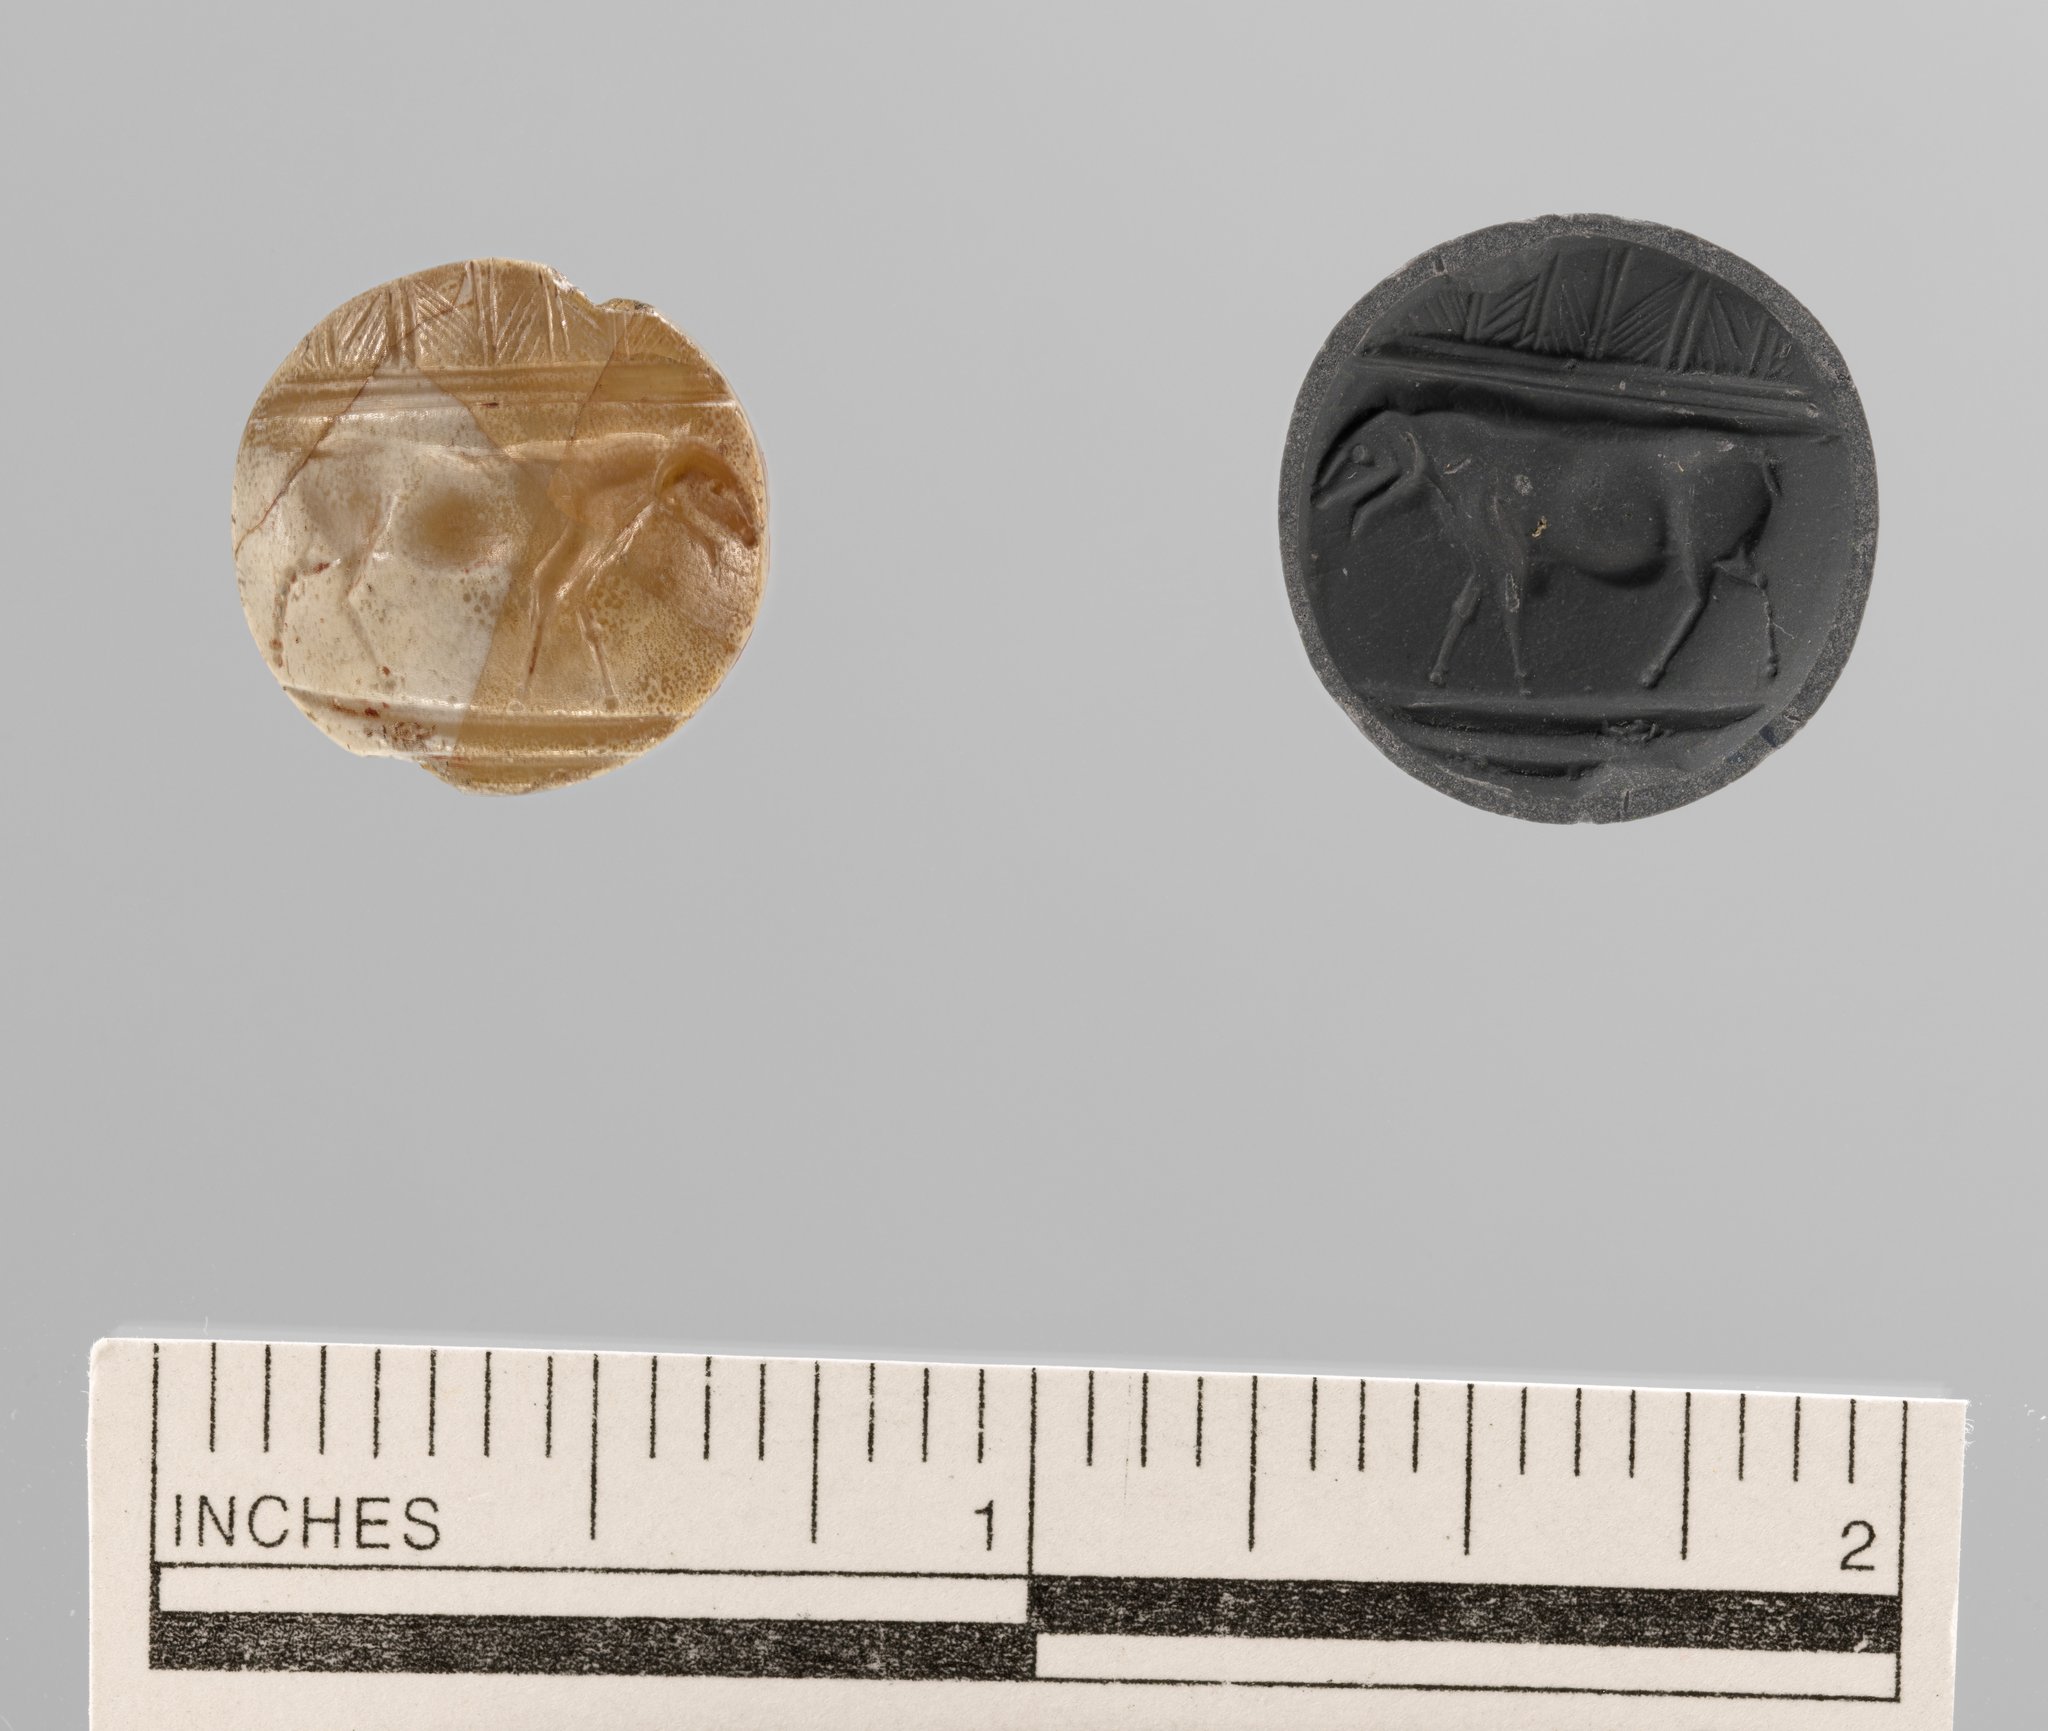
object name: seal, discoid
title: Chalcedony Disk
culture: minoan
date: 1700-1600 BCE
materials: stone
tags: rams